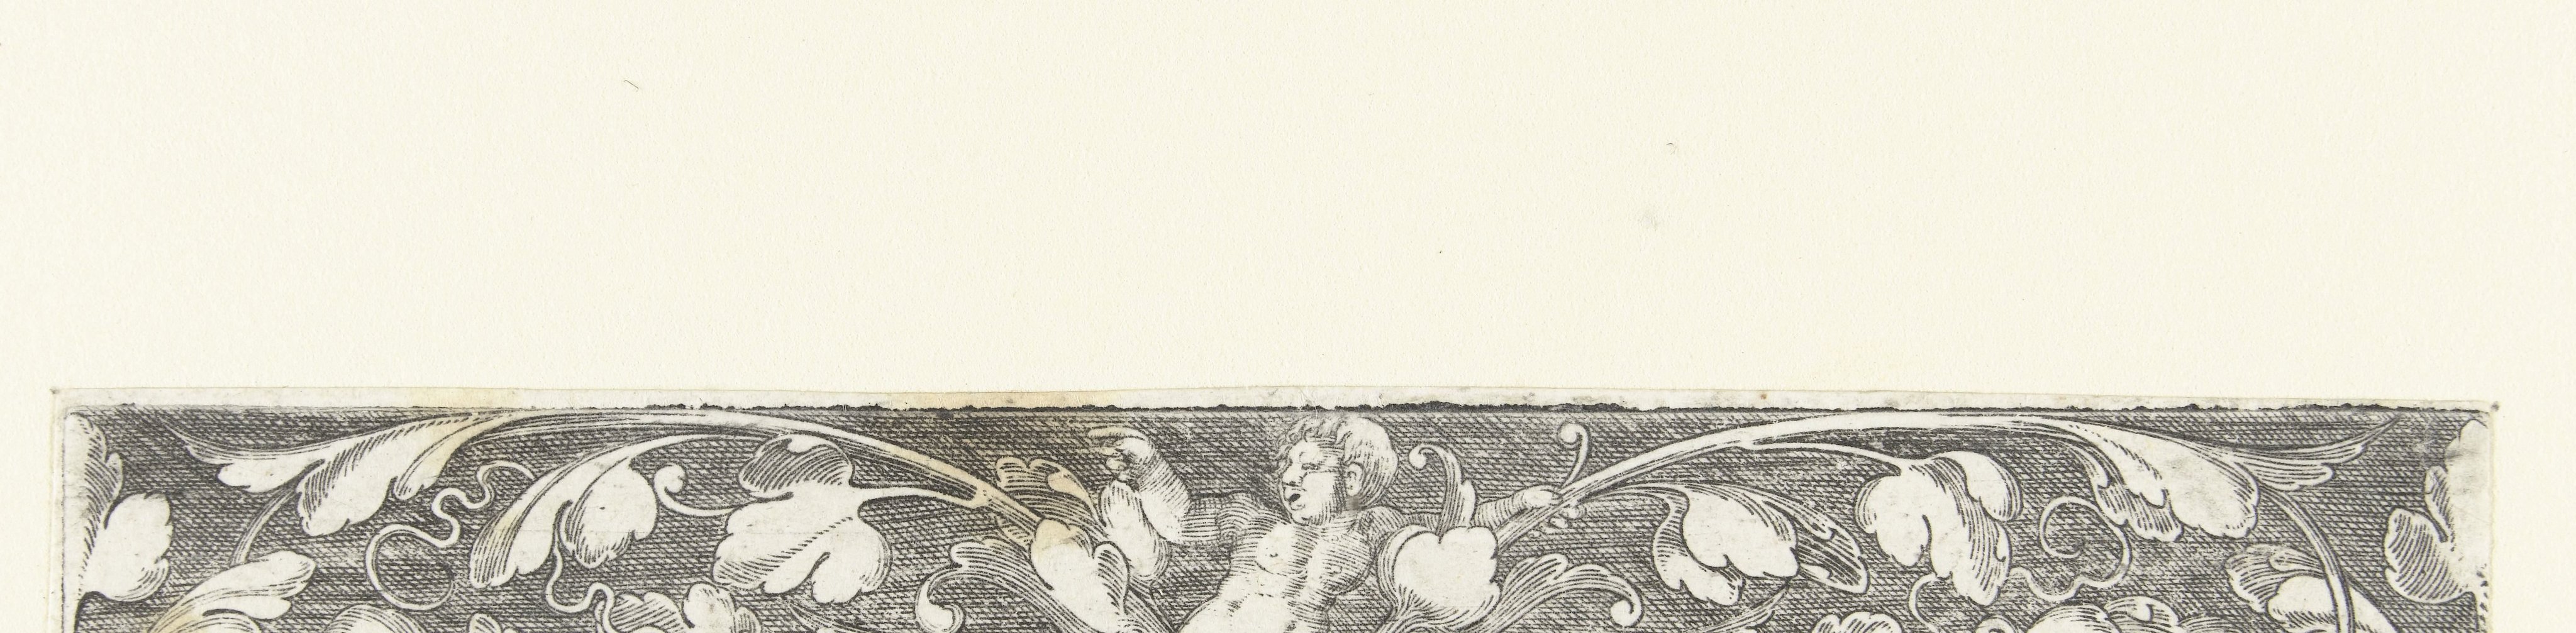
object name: print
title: Fries met bladranken ontspruitend vanuit een schildje in het midden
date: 1500-1600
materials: paper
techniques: engraving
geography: germany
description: Over het schildje heen staat wijdbeens een kind. Gearceerde achtergrond.